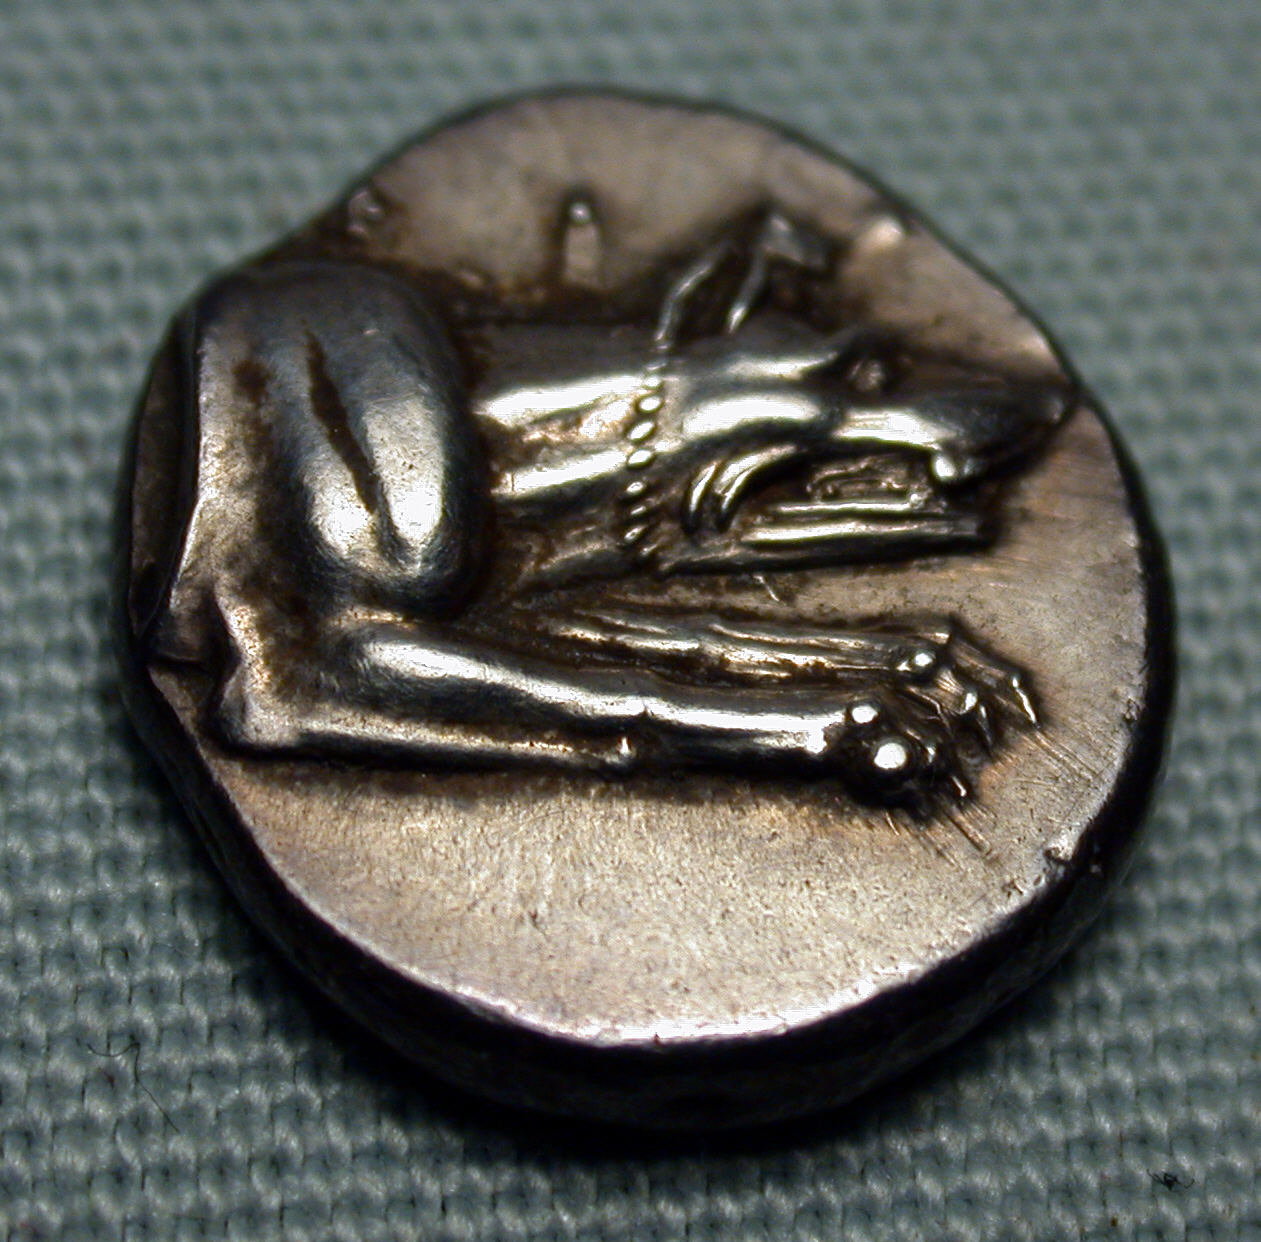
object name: triobol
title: Silver triobol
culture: greek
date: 330-270 BCE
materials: silver